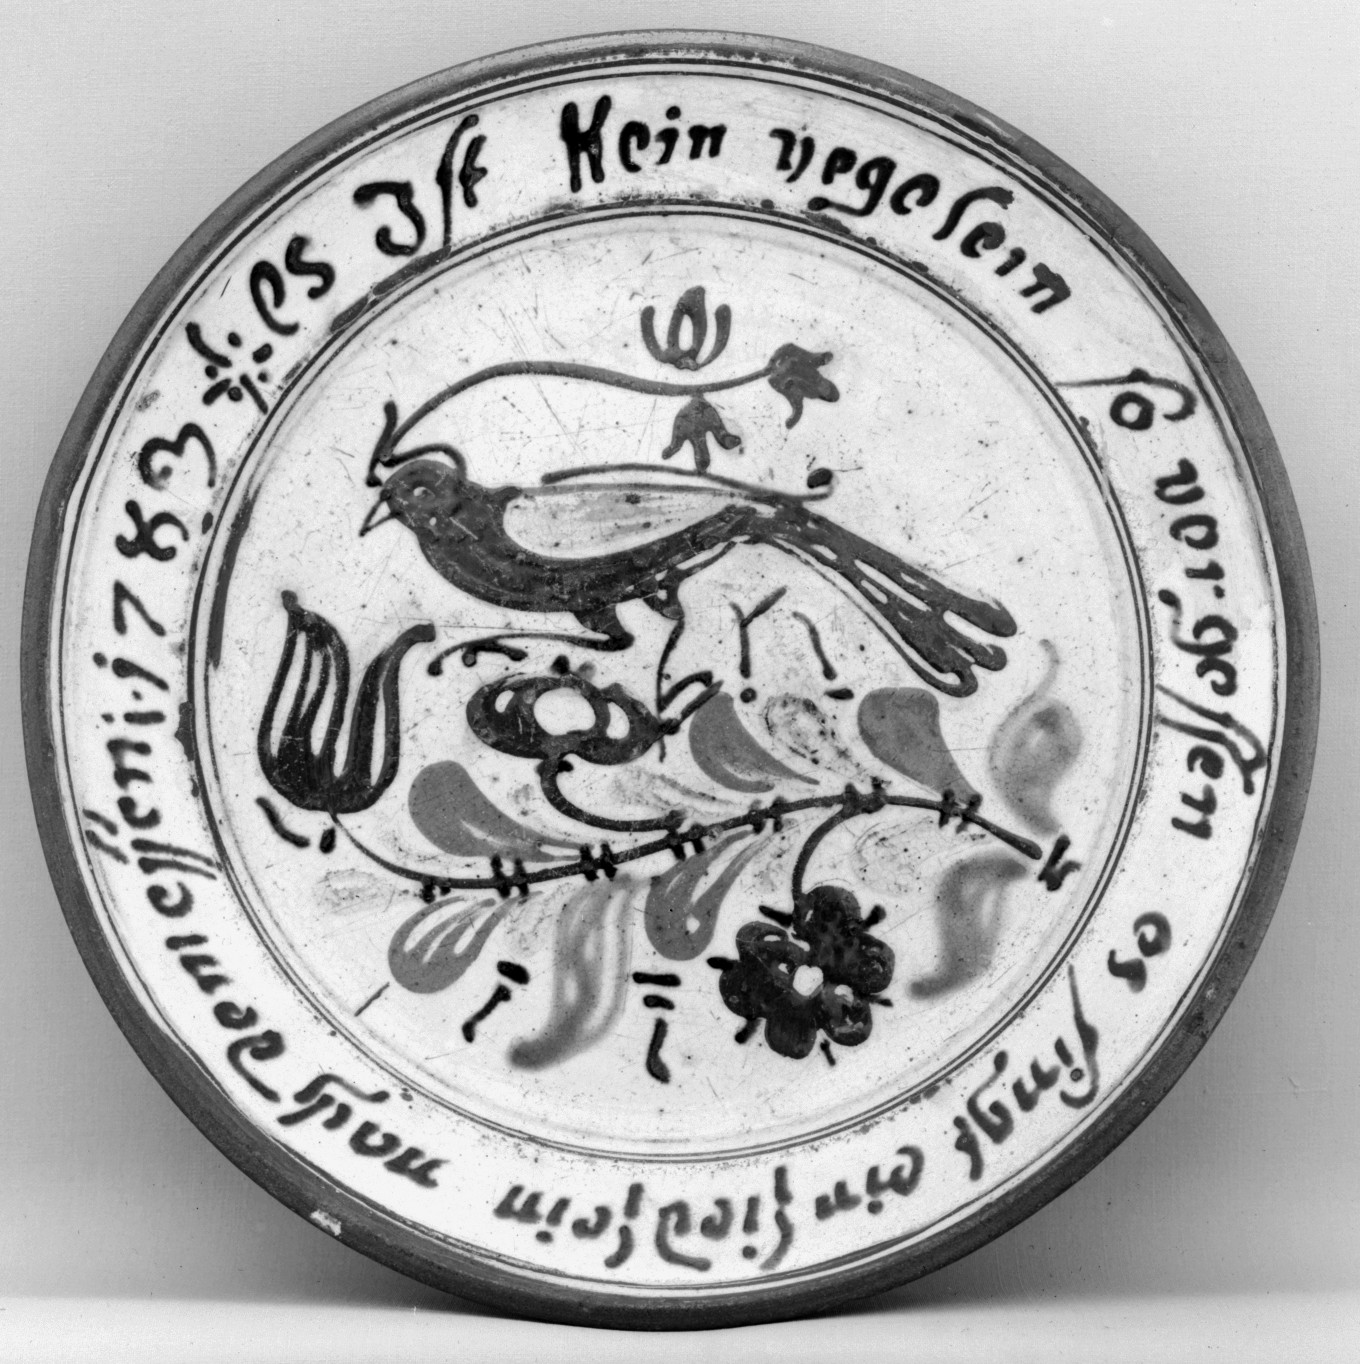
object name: plate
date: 1701-1800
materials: earthenware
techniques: glazing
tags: birds,flowers